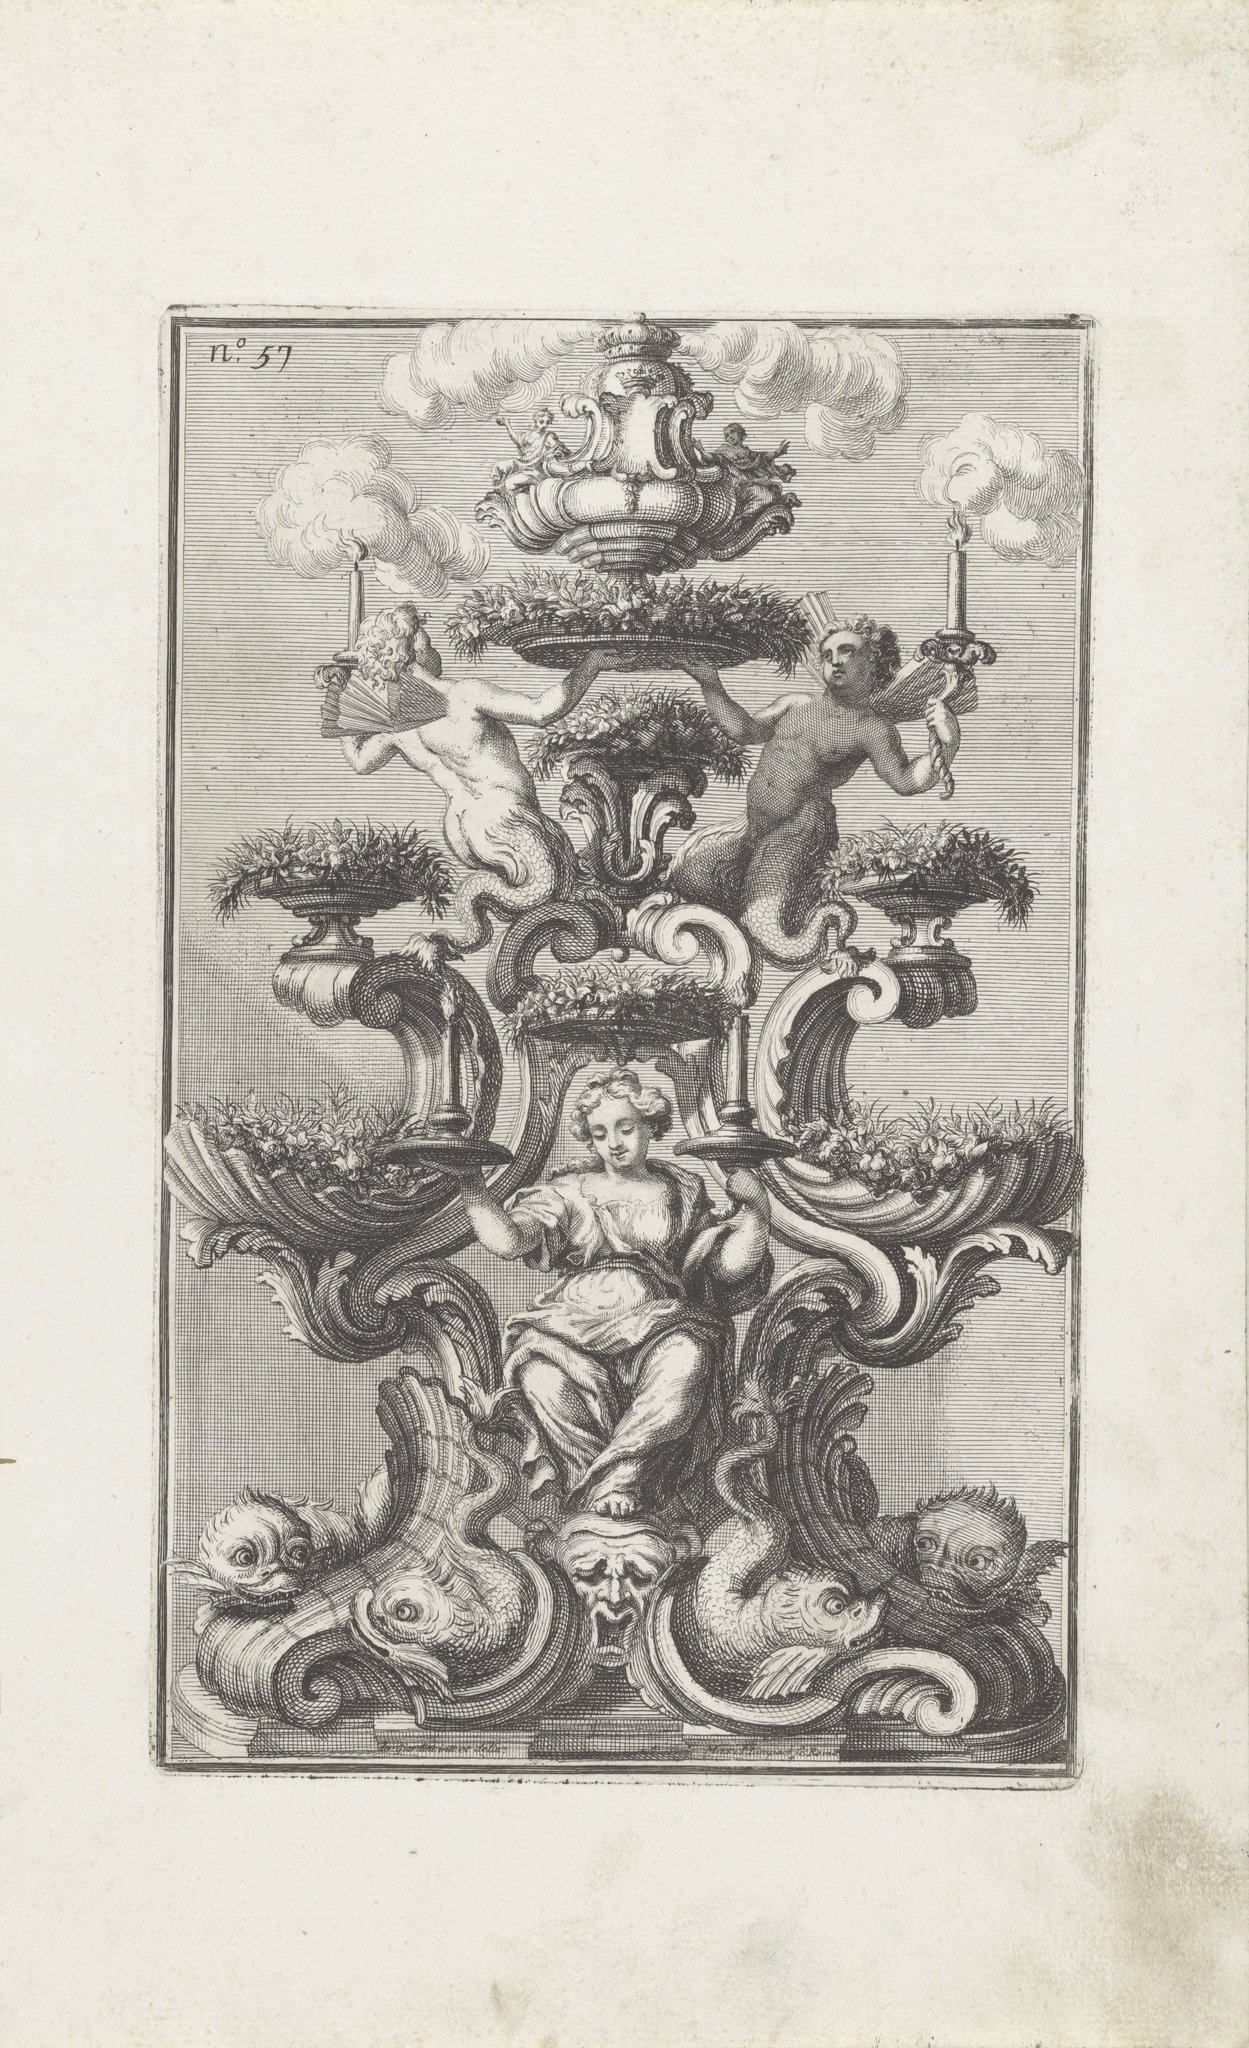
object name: print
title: Disegni diversi inventati e delineati da Giovanni Giardini da Forlì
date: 1714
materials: paper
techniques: etching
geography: italy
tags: dolphin ~ ornament, triton(s), censer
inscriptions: collector's mark: Lugt 2228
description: Prent maakt deel uit van een reeks van 100 ornamentprenten naar ontwerp van Giovanni Giardini.